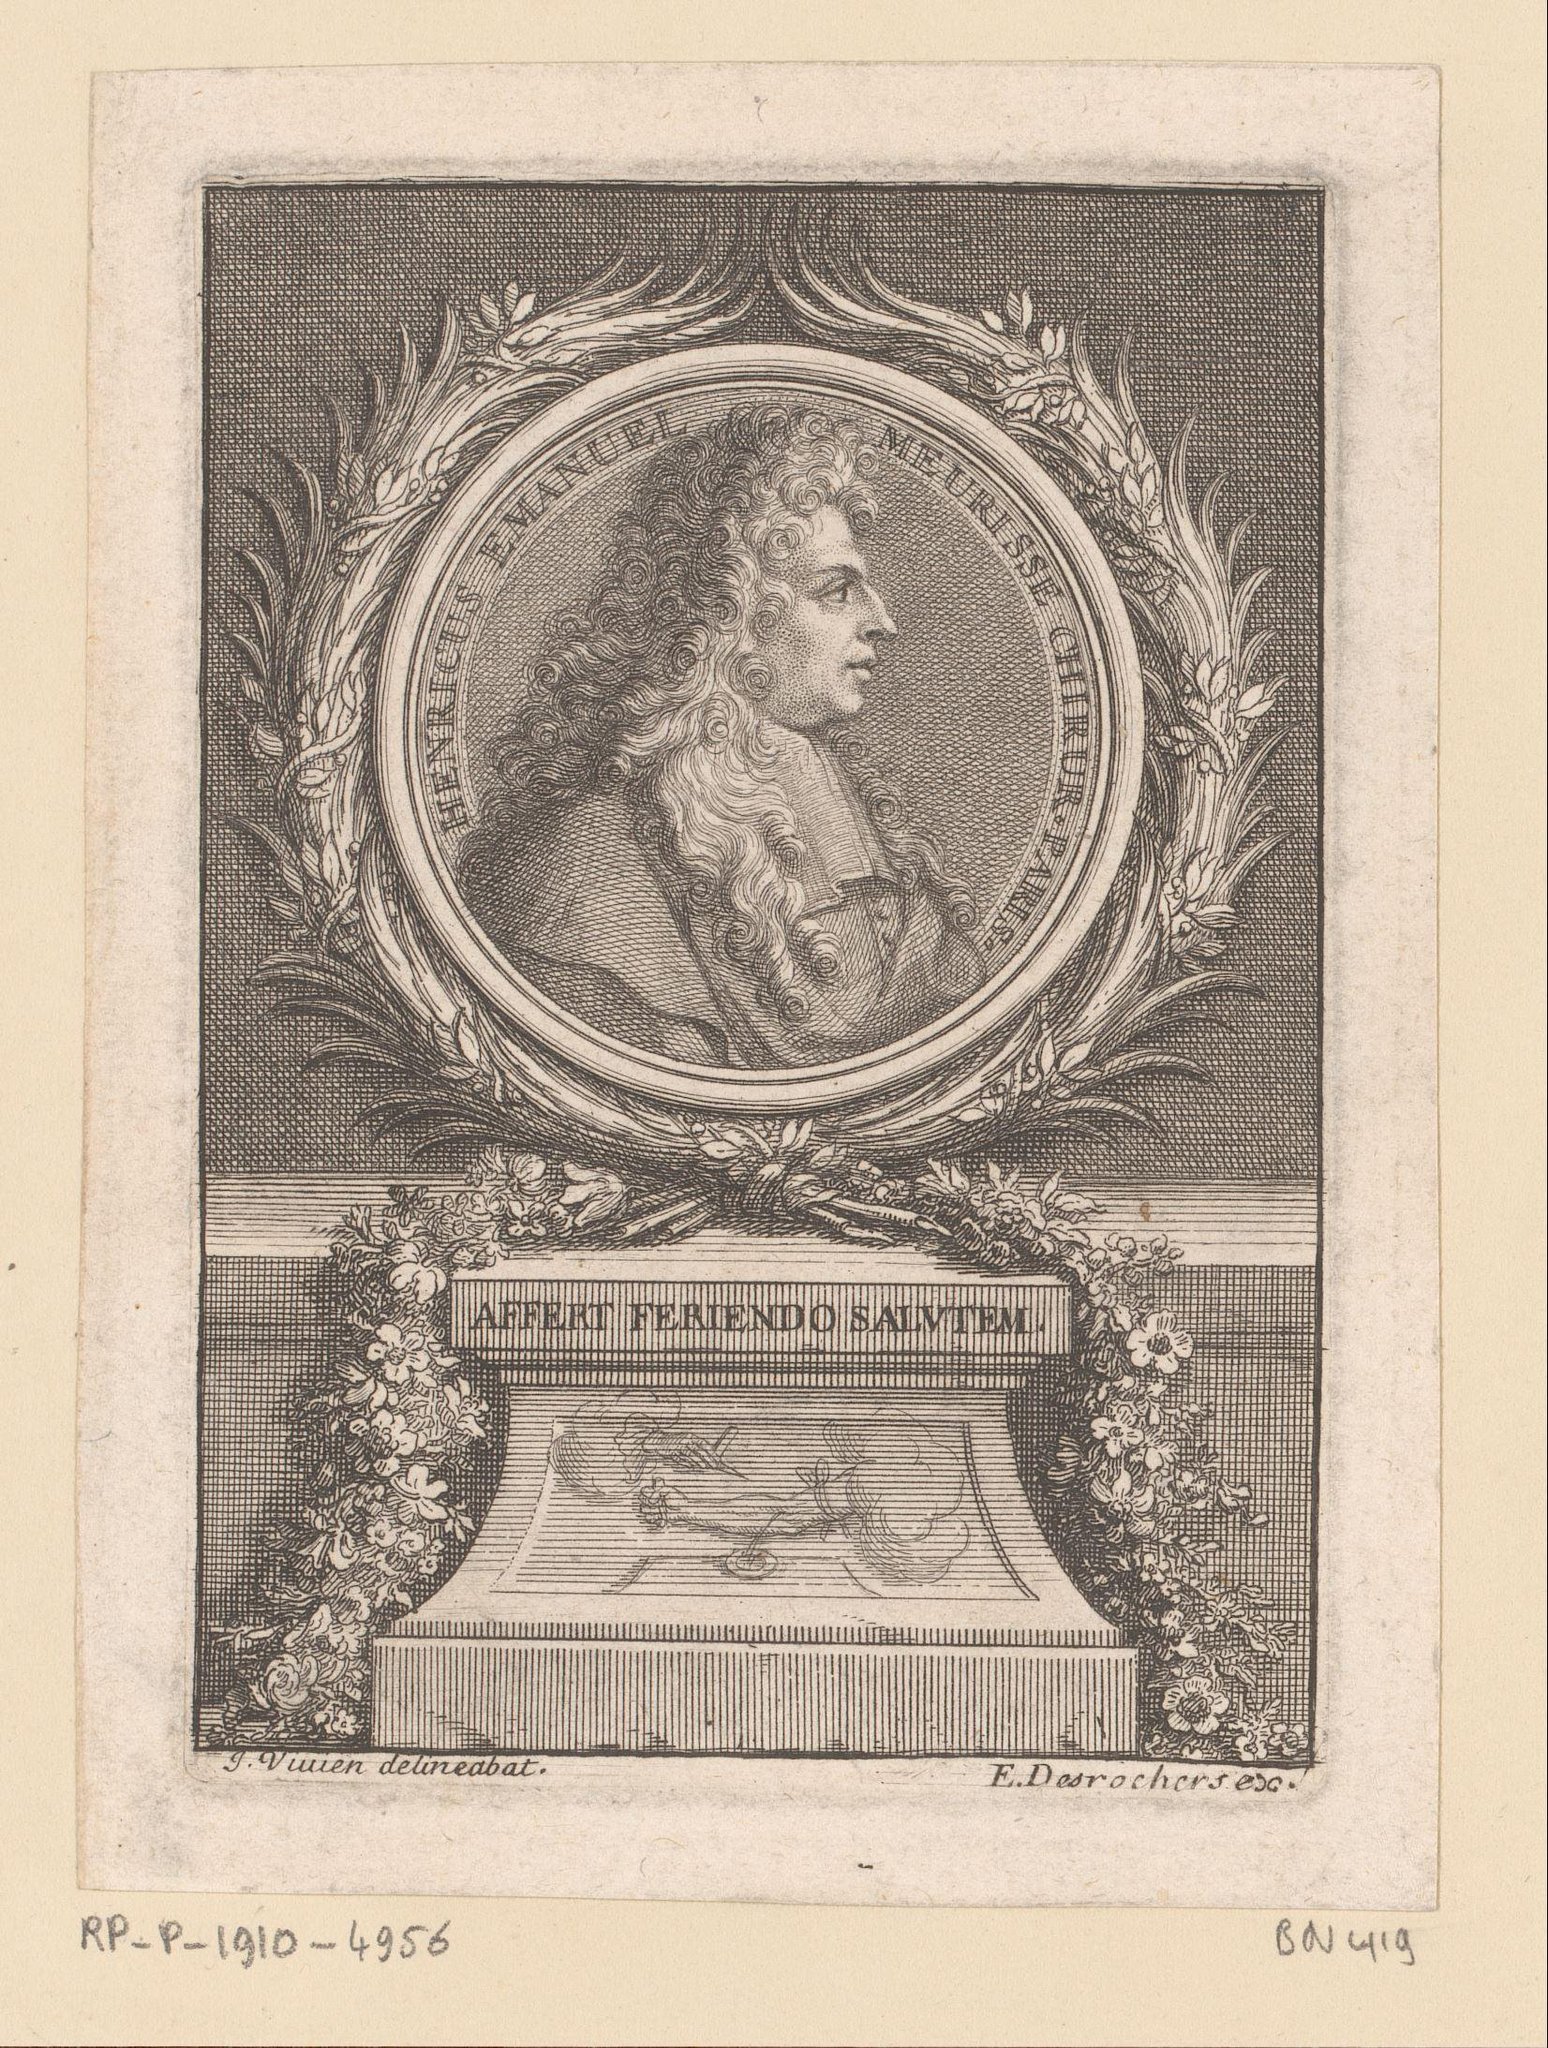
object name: print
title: Portret van Henri Emmanuel Meurisse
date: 1678-1741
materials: paper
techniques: engraving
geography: paris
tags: historical persons, barber; surgeon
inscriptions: collector's mark: Lugt 2228